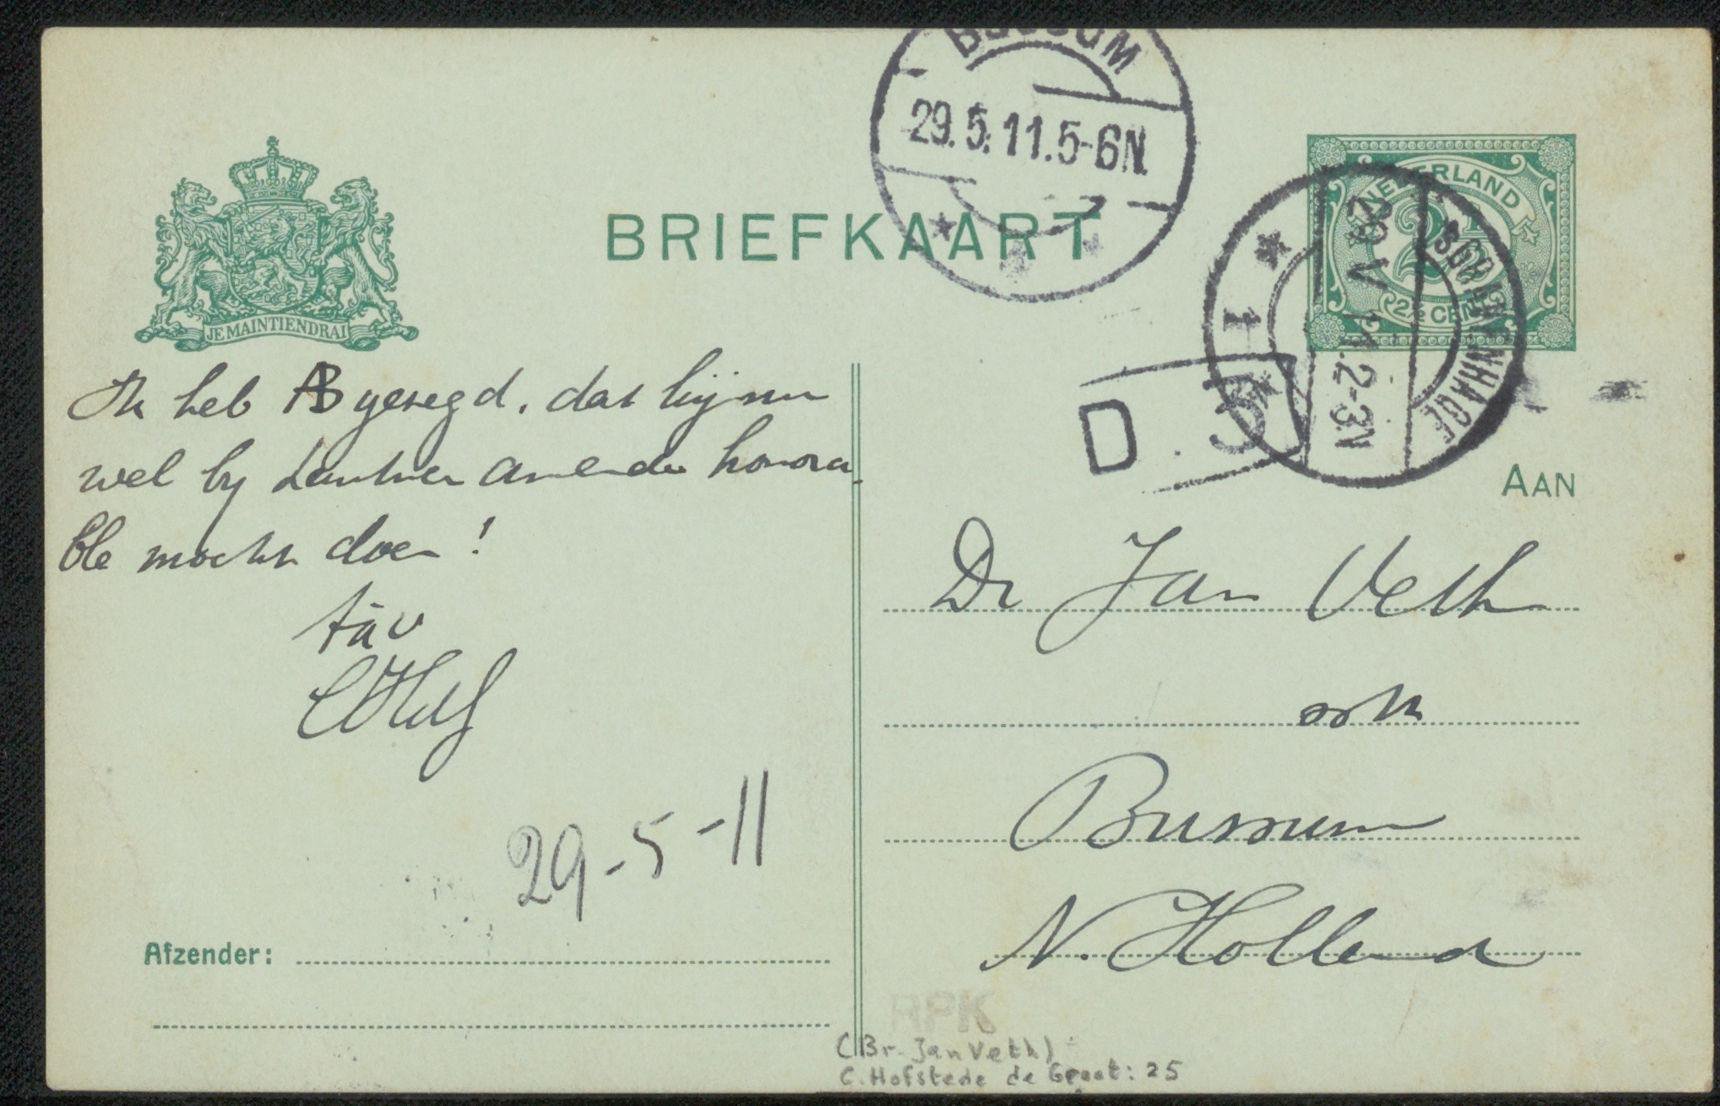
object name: postcard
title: Briefkaart aan Jan Veth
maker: cornelis hofstede de groot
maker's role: kunsthistoricus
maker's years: 1863-1940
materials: cardboard, ink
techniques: pen, writing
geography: the hague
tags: ferdinand bol, dordrecht, designer, jan veth, delft, carel fabritius, leiden, amsterdam, painter, print maker, draughtsman, rembrandt van rijn, painting (including book-illumination, miniature-painting)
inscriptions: collector's mark: ‘RPK’